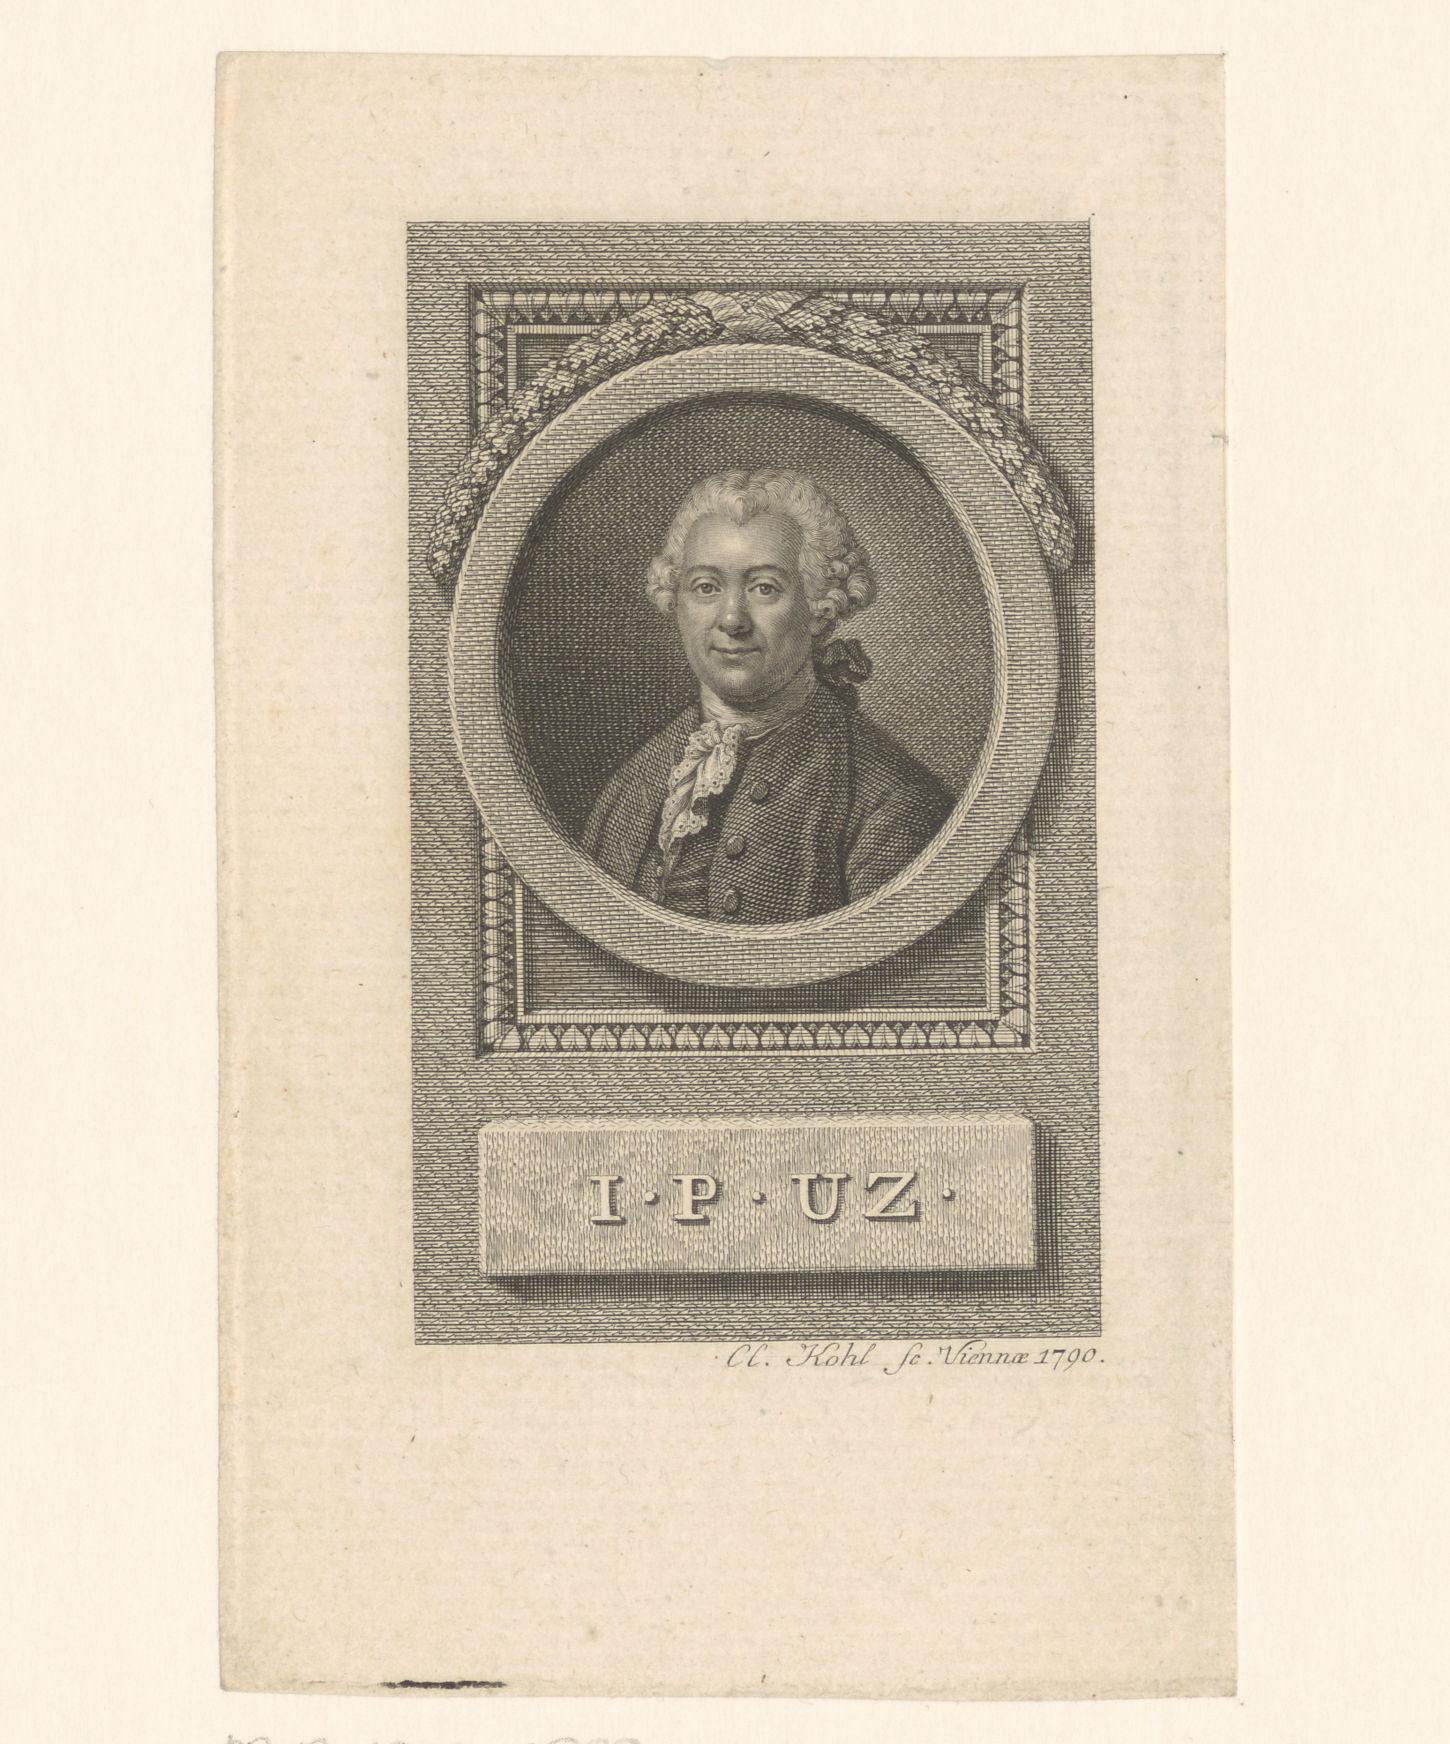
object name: print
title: Portret van Johann Peter Uz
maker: clemens kohl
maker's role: draughtsman, print maker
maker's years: 1754-1807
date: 1790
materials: paper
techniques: engraving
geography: vienna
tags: historical persons, writer, poet, author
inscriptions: collector's mark: Lugt 2228